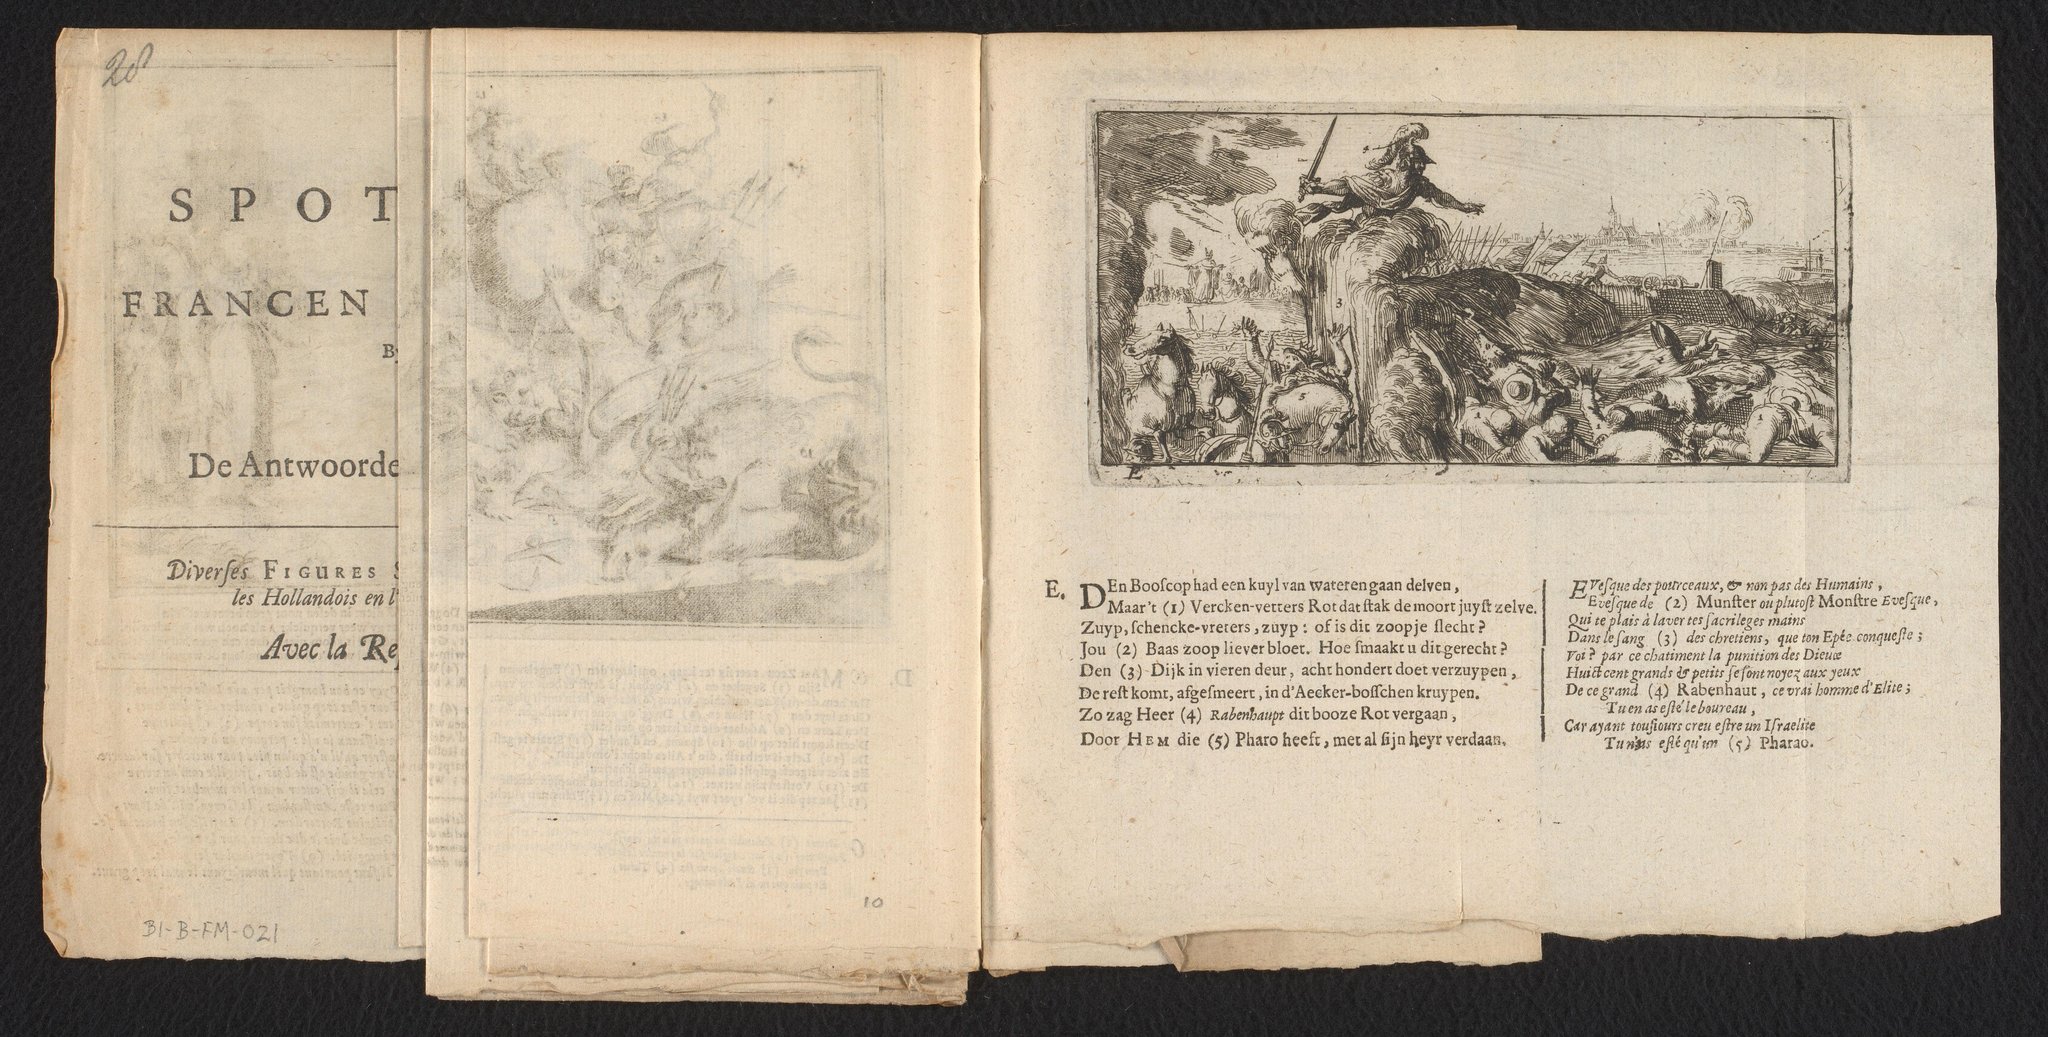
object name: print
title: Hollands antwoord op De moedige Batavieren, 1673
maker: romeyn de hooghe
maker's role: draughtsman, goldsmith, painter, print maker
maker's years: 1645-1708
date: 1673-1674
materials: paper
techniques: engraving, etching, letterpress printing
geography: northern netherlands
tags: dike-break, political caricatures and satires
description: Hollands antwoord op de Franse spotprent De moedige Batavieren, 1673. De bisschoppelijke legers worden door het water van de doorgebroken dijk bij Coevorden (1672) gelijk het leger van Farao weggespoeld. Op de golven staat Rabenhaupt met zwaard. Met onderschriften in het Nederlands en Frans.